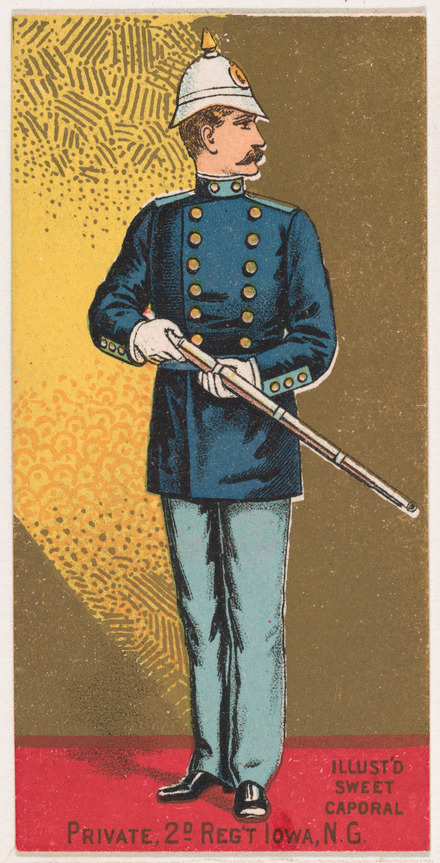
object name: print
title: Private, 2nd Regiment, Iowa, National Guard, from the Military Series (N224) issued by Kinney Tobacco Company to promote Sweet Caporal Cigarettes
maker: kinney brothers tobacco company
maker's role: publisher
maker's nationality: american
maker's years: 1869-2011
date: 1888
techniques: color lithograph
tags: military,men